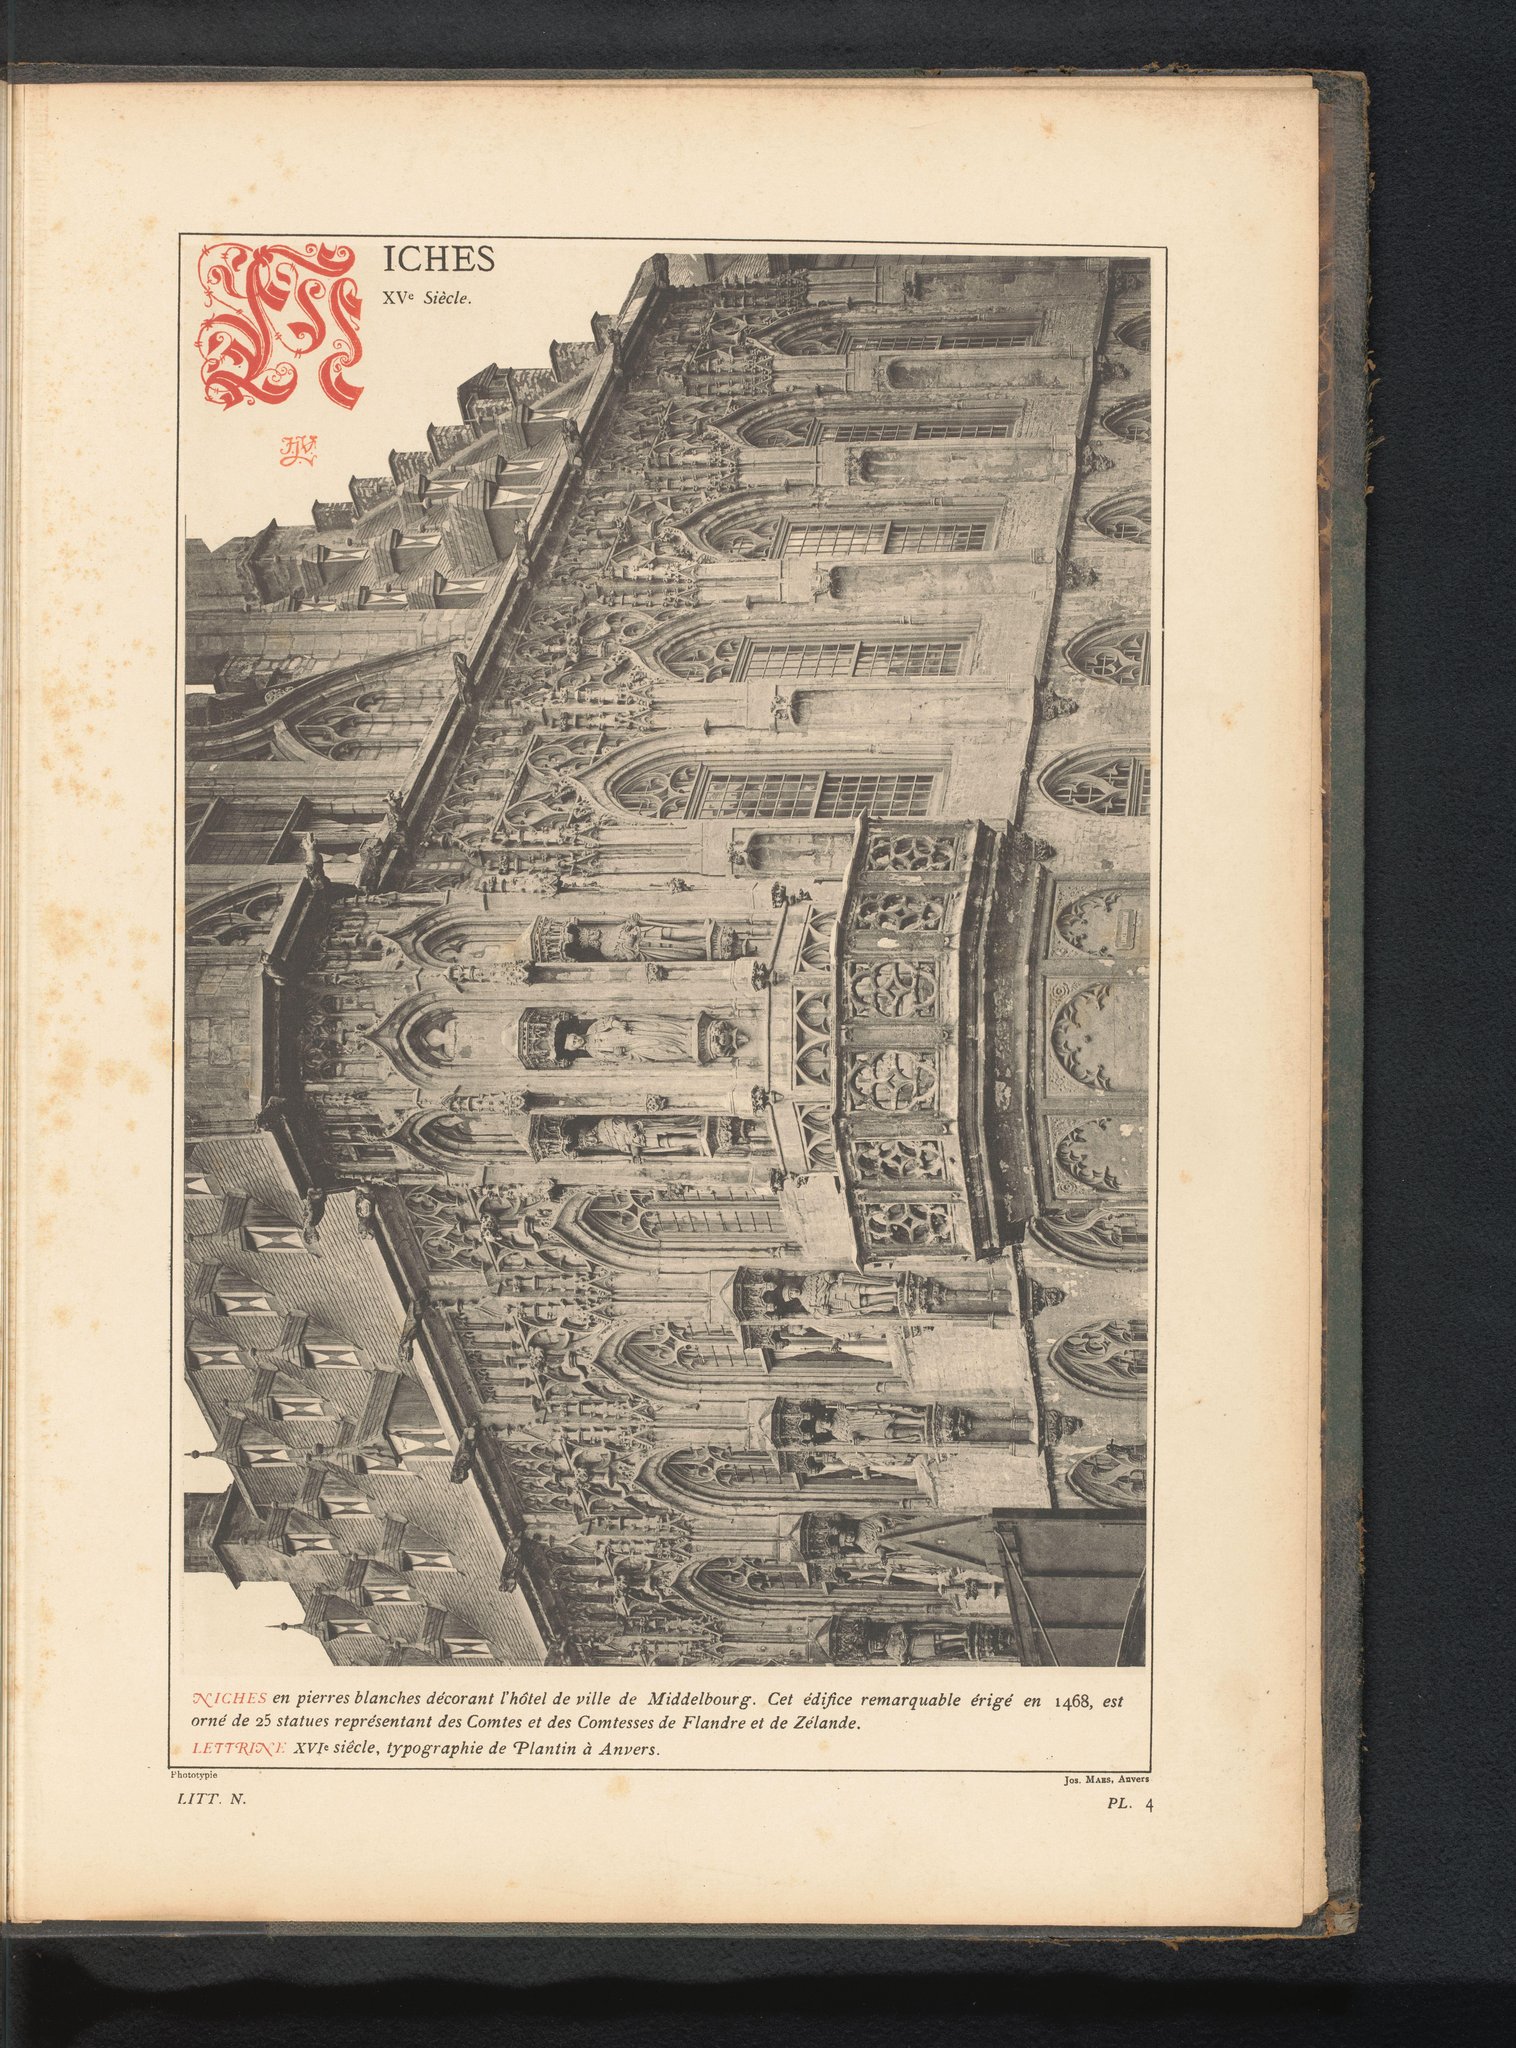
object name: photomechanical print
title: Gezicht op een hoek van het stadhuis van Middelburg met beelden in nissen van graven en gravinnen van Vlaanderen en Zeeland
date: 1875-1880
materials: paper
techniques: photograph, photolithography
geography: middelburg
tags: townhall, sculpture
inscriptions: inscription: ‘NICHES en pierres (...)’, monogram: ‘JJvY’, inscription: ‘LITT. N. - PL. 4’